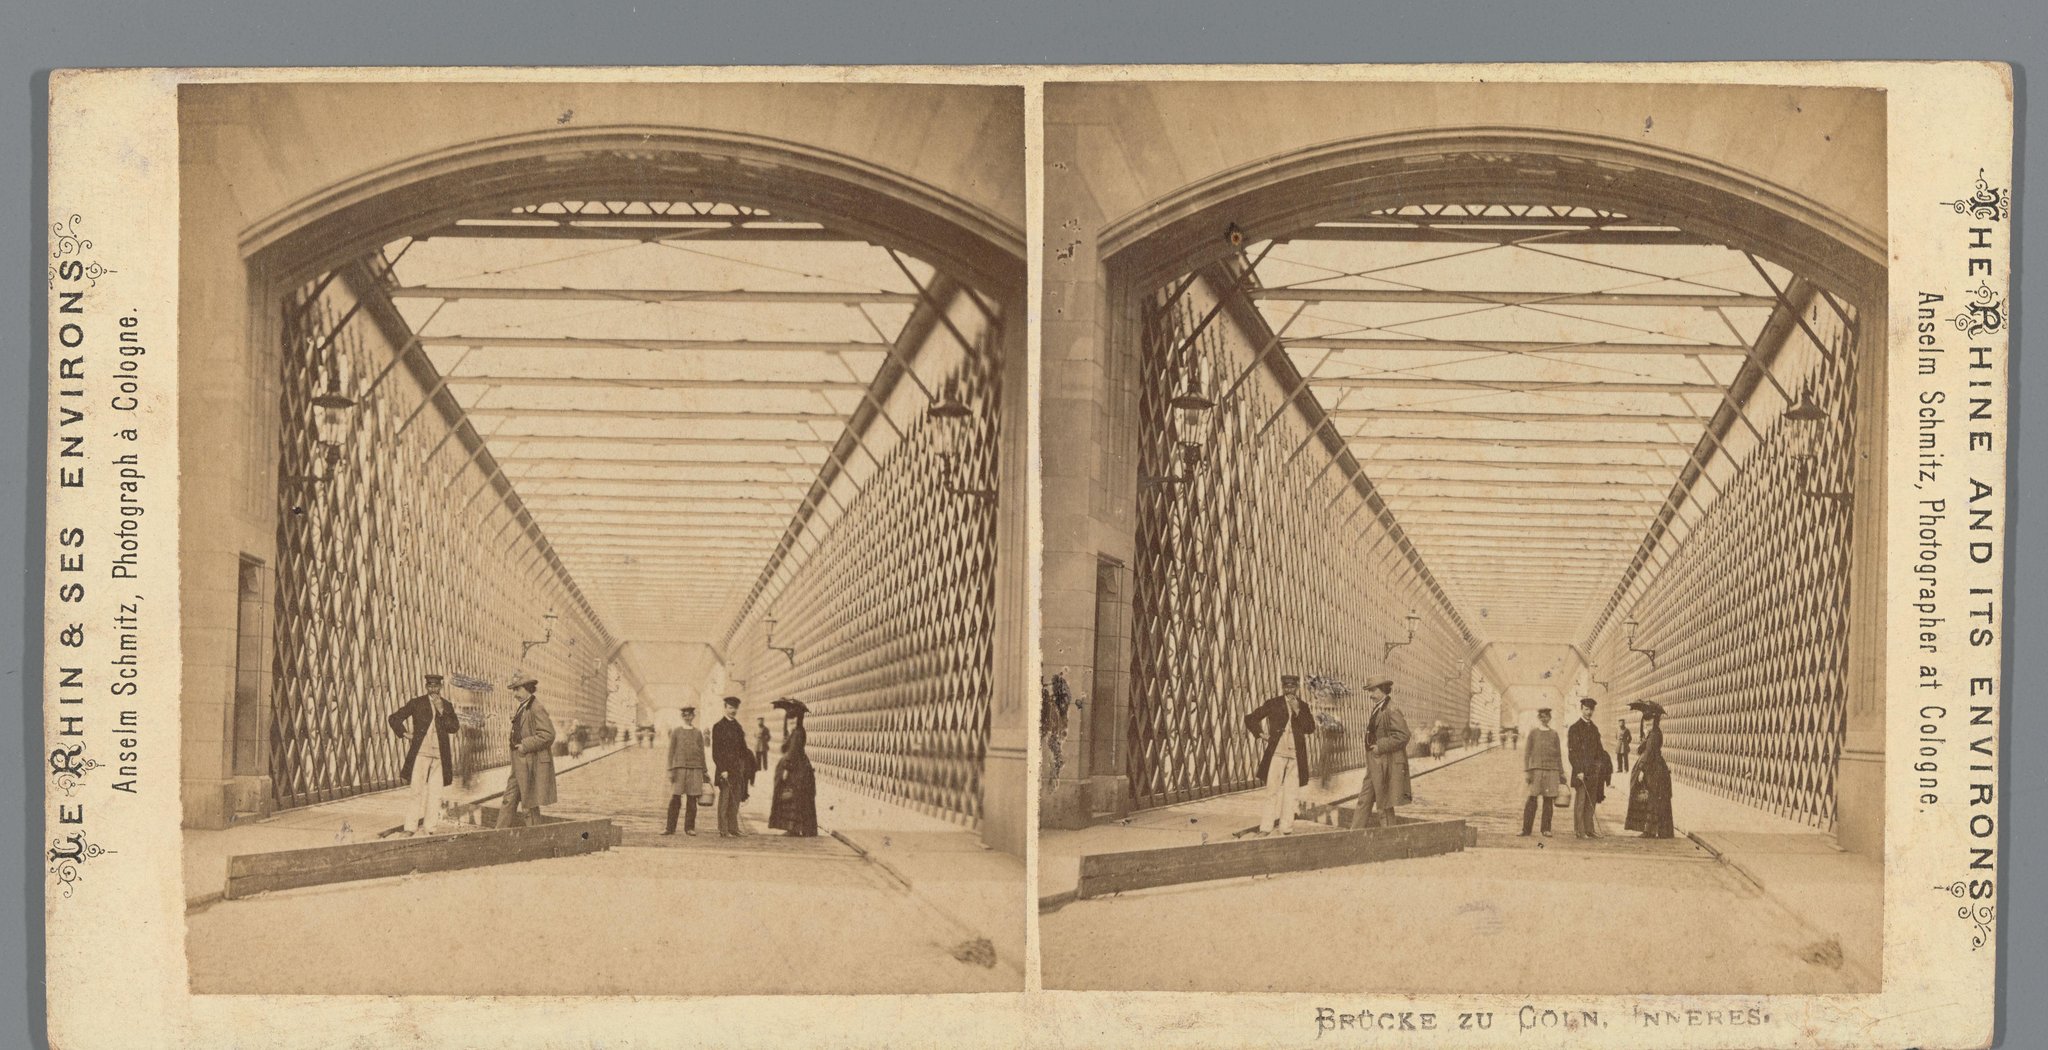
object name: stereograph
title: Gezelschap poserend bij de ingang van de Dombrug (Dombrücke) in Keulen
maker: anselm schmitz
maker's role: publisher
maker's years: 1831-1903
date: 1860-1880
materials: cardboard, paper, photographic support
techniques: albumen print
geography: cologne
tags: railway, train, bridge, cologne